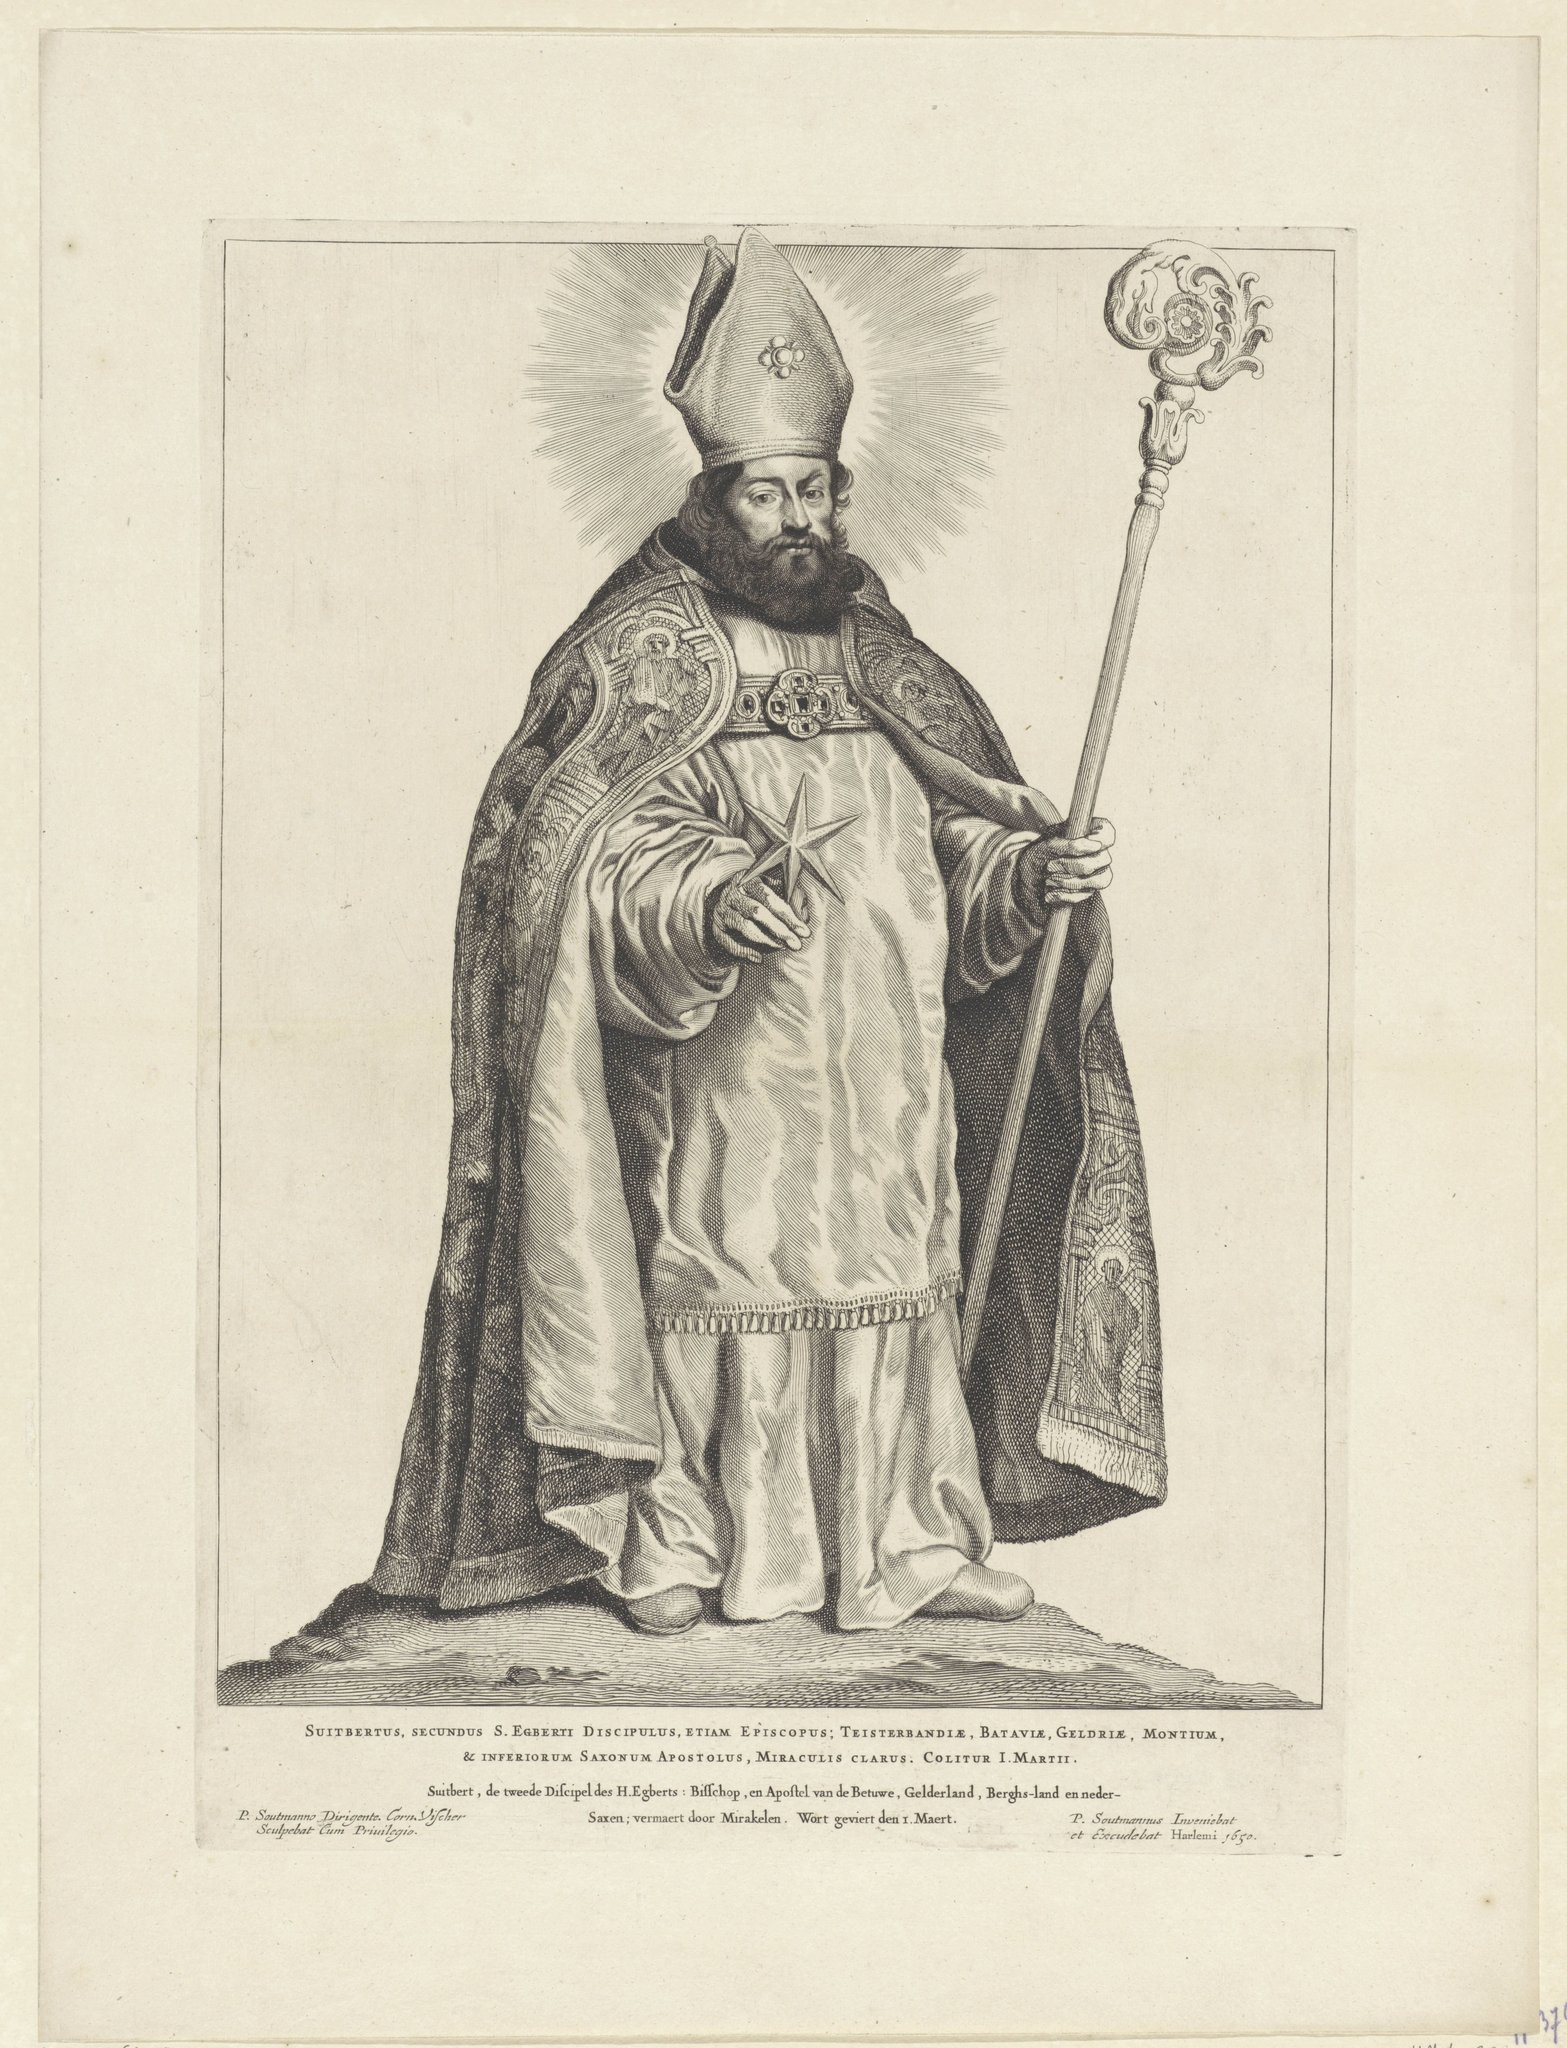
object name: print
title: H. Swietbertus van Teisterbant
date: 1650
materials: paper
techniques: engraving, etching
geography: haarlem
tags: northumberland, keizersweerd, bisschop, swietbertus van teisterbant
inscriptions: collector's mark: Lugt 240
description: Deze prent maakt deel uit van de serie: Iesv Christo, Fideli Militantis Ecclesiae Imperatori, Liberali Eivsdem, Trivmphantis, Remvneratori, hos In Foederato Belgio Militiae Svae Legatos, Sanctissimos Sacri Belli Dvces, Patriae Apostolos, Et Decora Lvmina, Cvm Dvabvs Heroinis, Militans In Iisdem Provinciis Ecclesia. Haarlem: Pieter Claesz. Soutman, 1650.